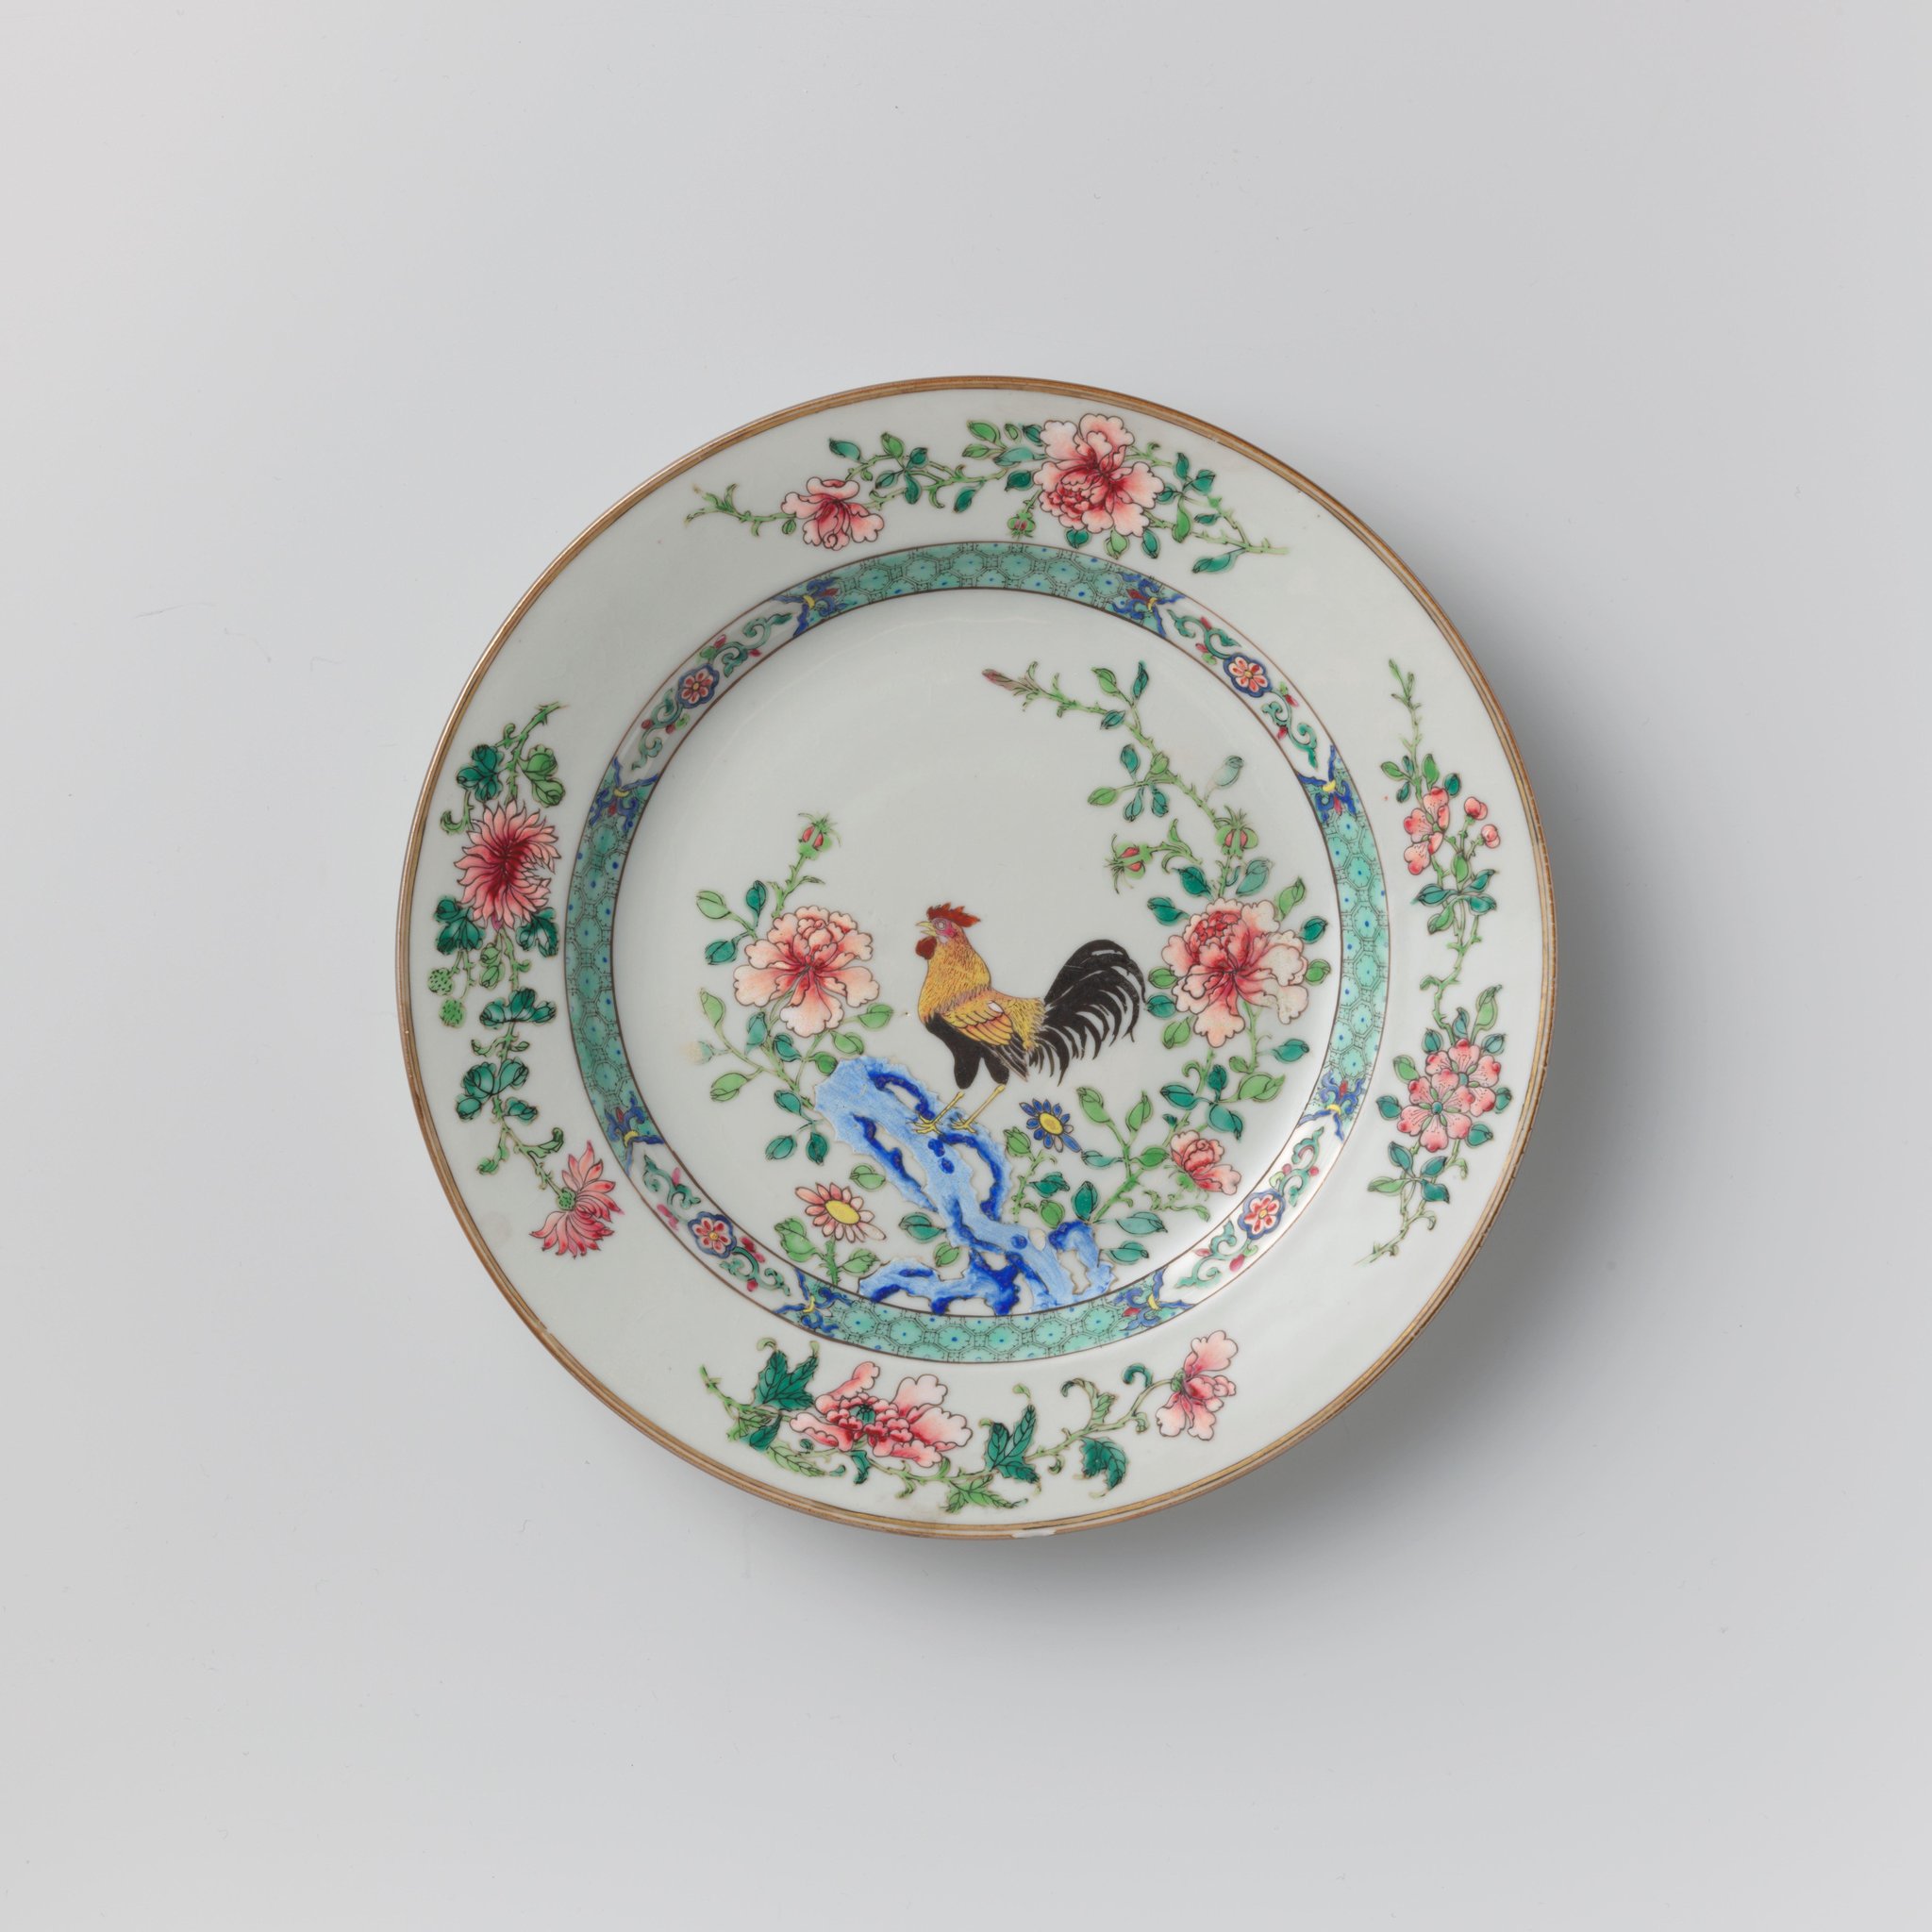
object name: plate dish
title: Plate with a cock on a rock near flowering plants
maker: Anonymous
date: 1725-1749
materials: glaze, paint, porcelain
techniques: firing, turning, vitrification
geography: china